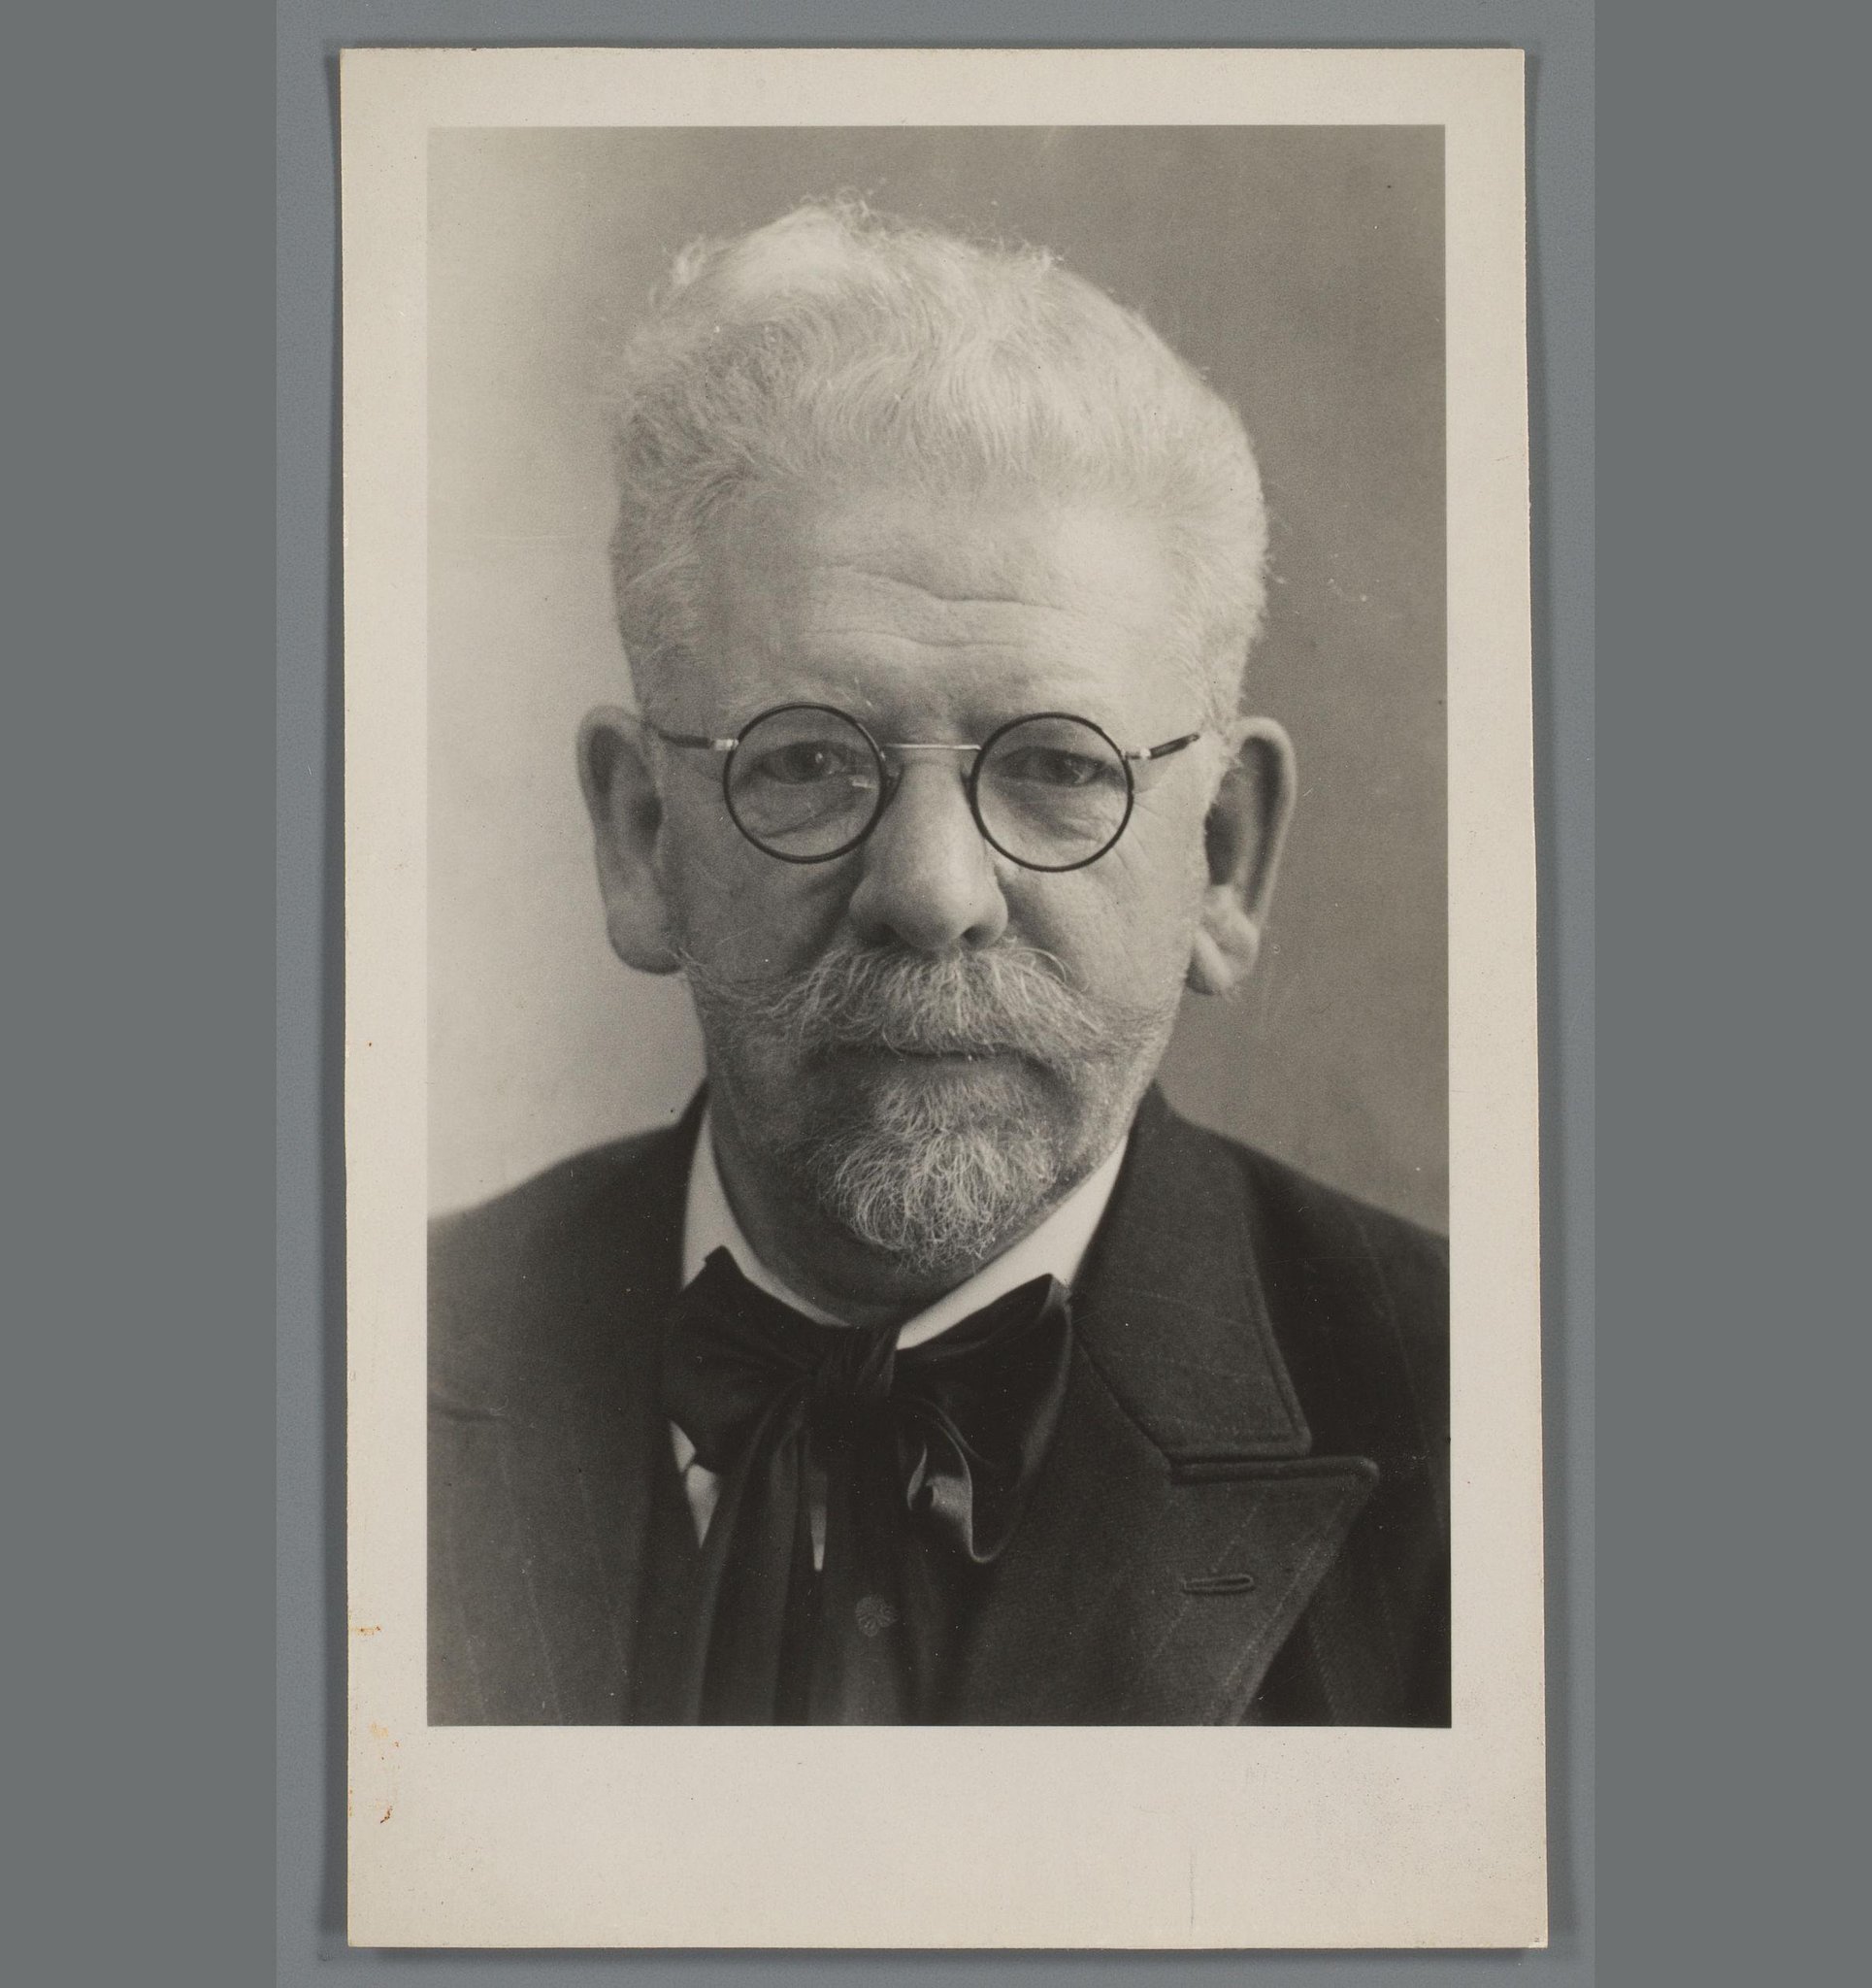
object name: photograph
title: Portret van Jacob Olie junior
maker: Anonymous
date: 1940-1955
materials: paper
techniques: gelatin silver print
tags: amsterdam, utrecht, jacob olie jr., portrait, self-portrait of photographer